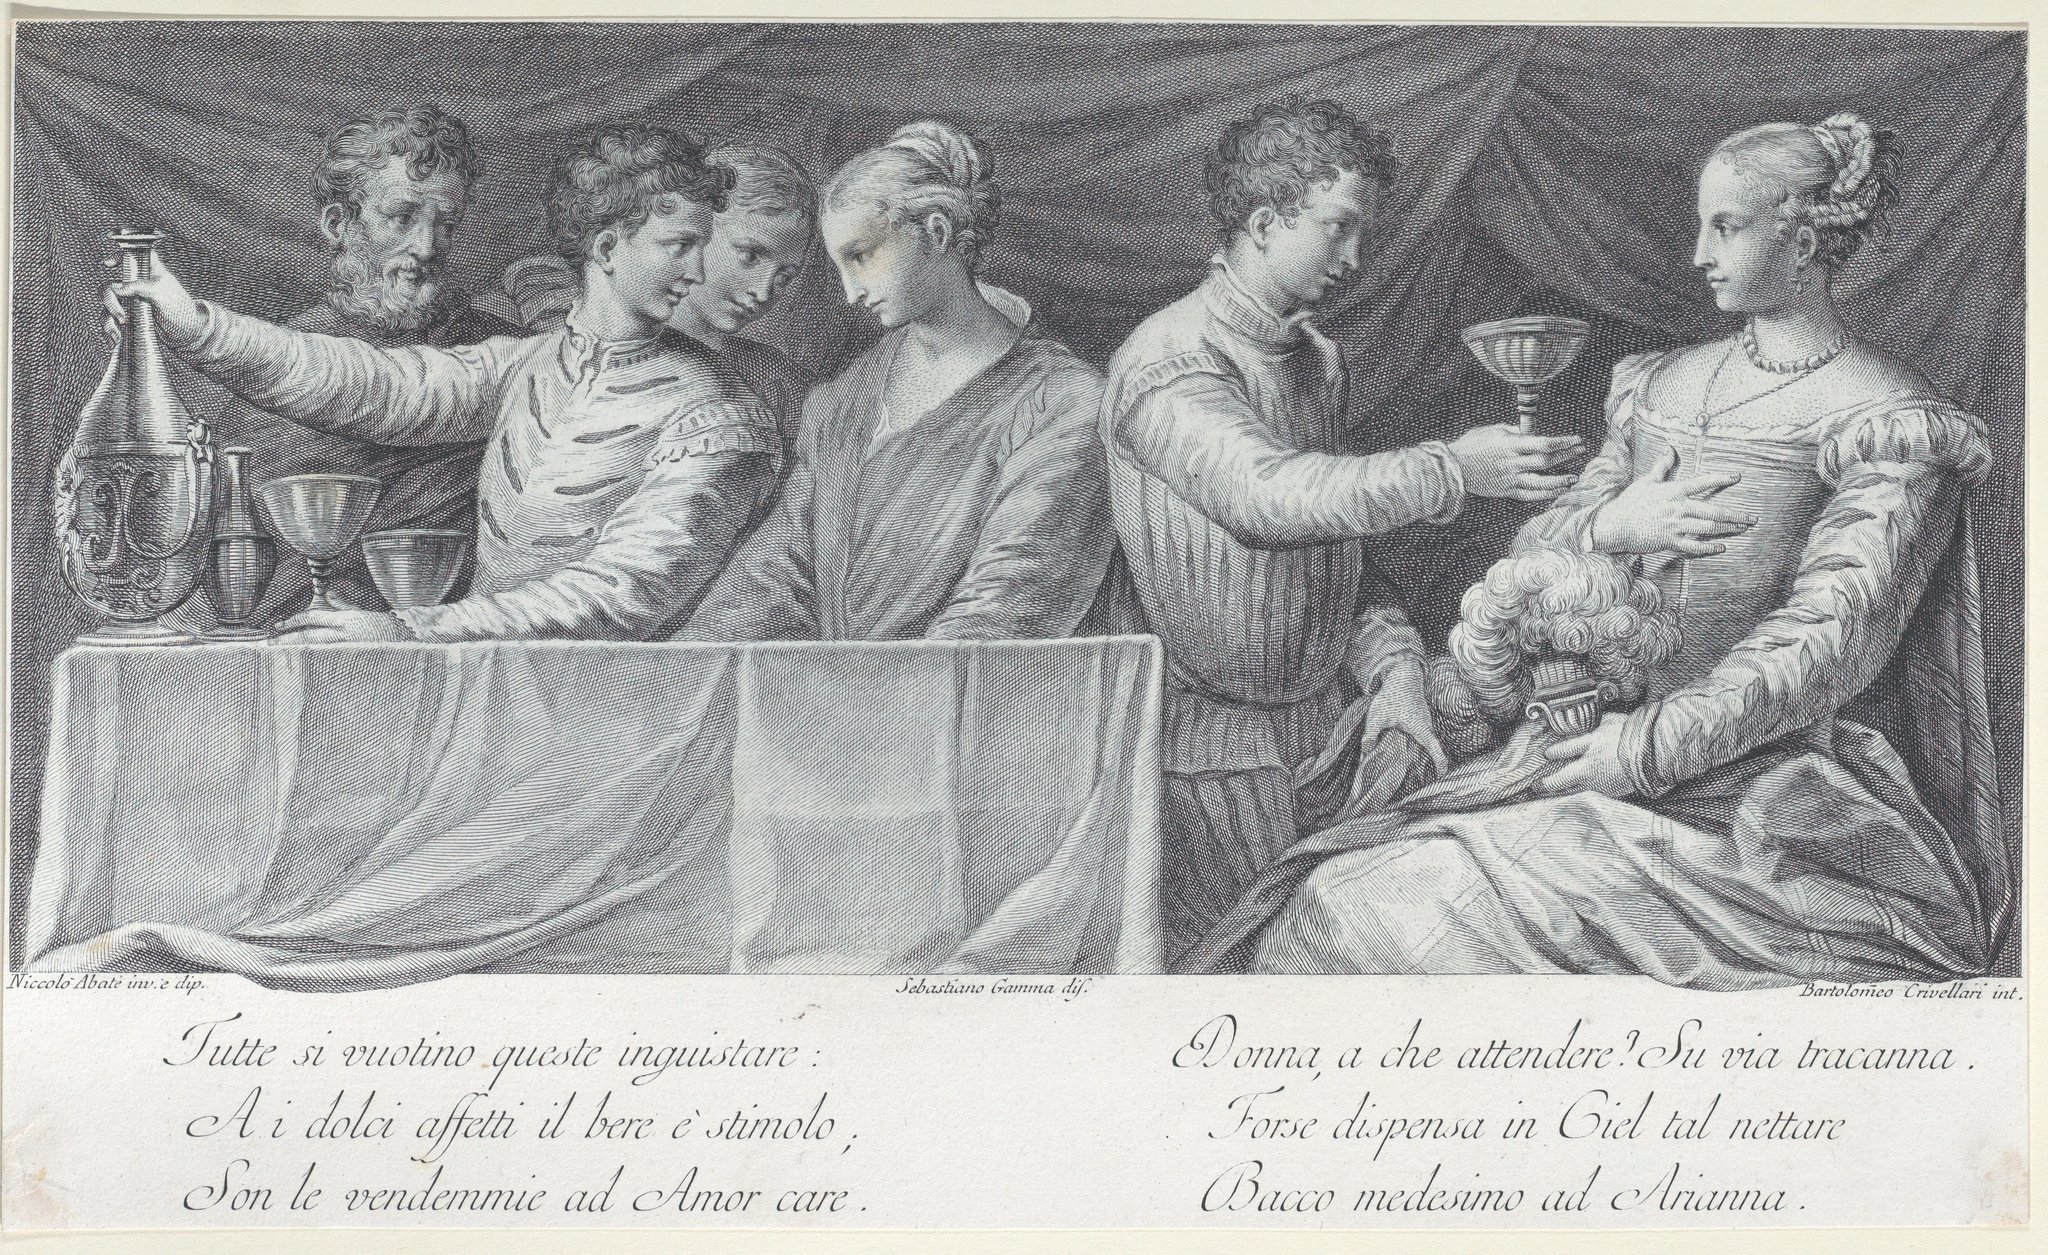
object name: print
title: A group of elegantly dressed people drinking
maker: bartolomeo crivellari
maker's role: artist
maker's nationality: italian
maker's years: 1700-1800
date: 1740-1768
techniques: engraving